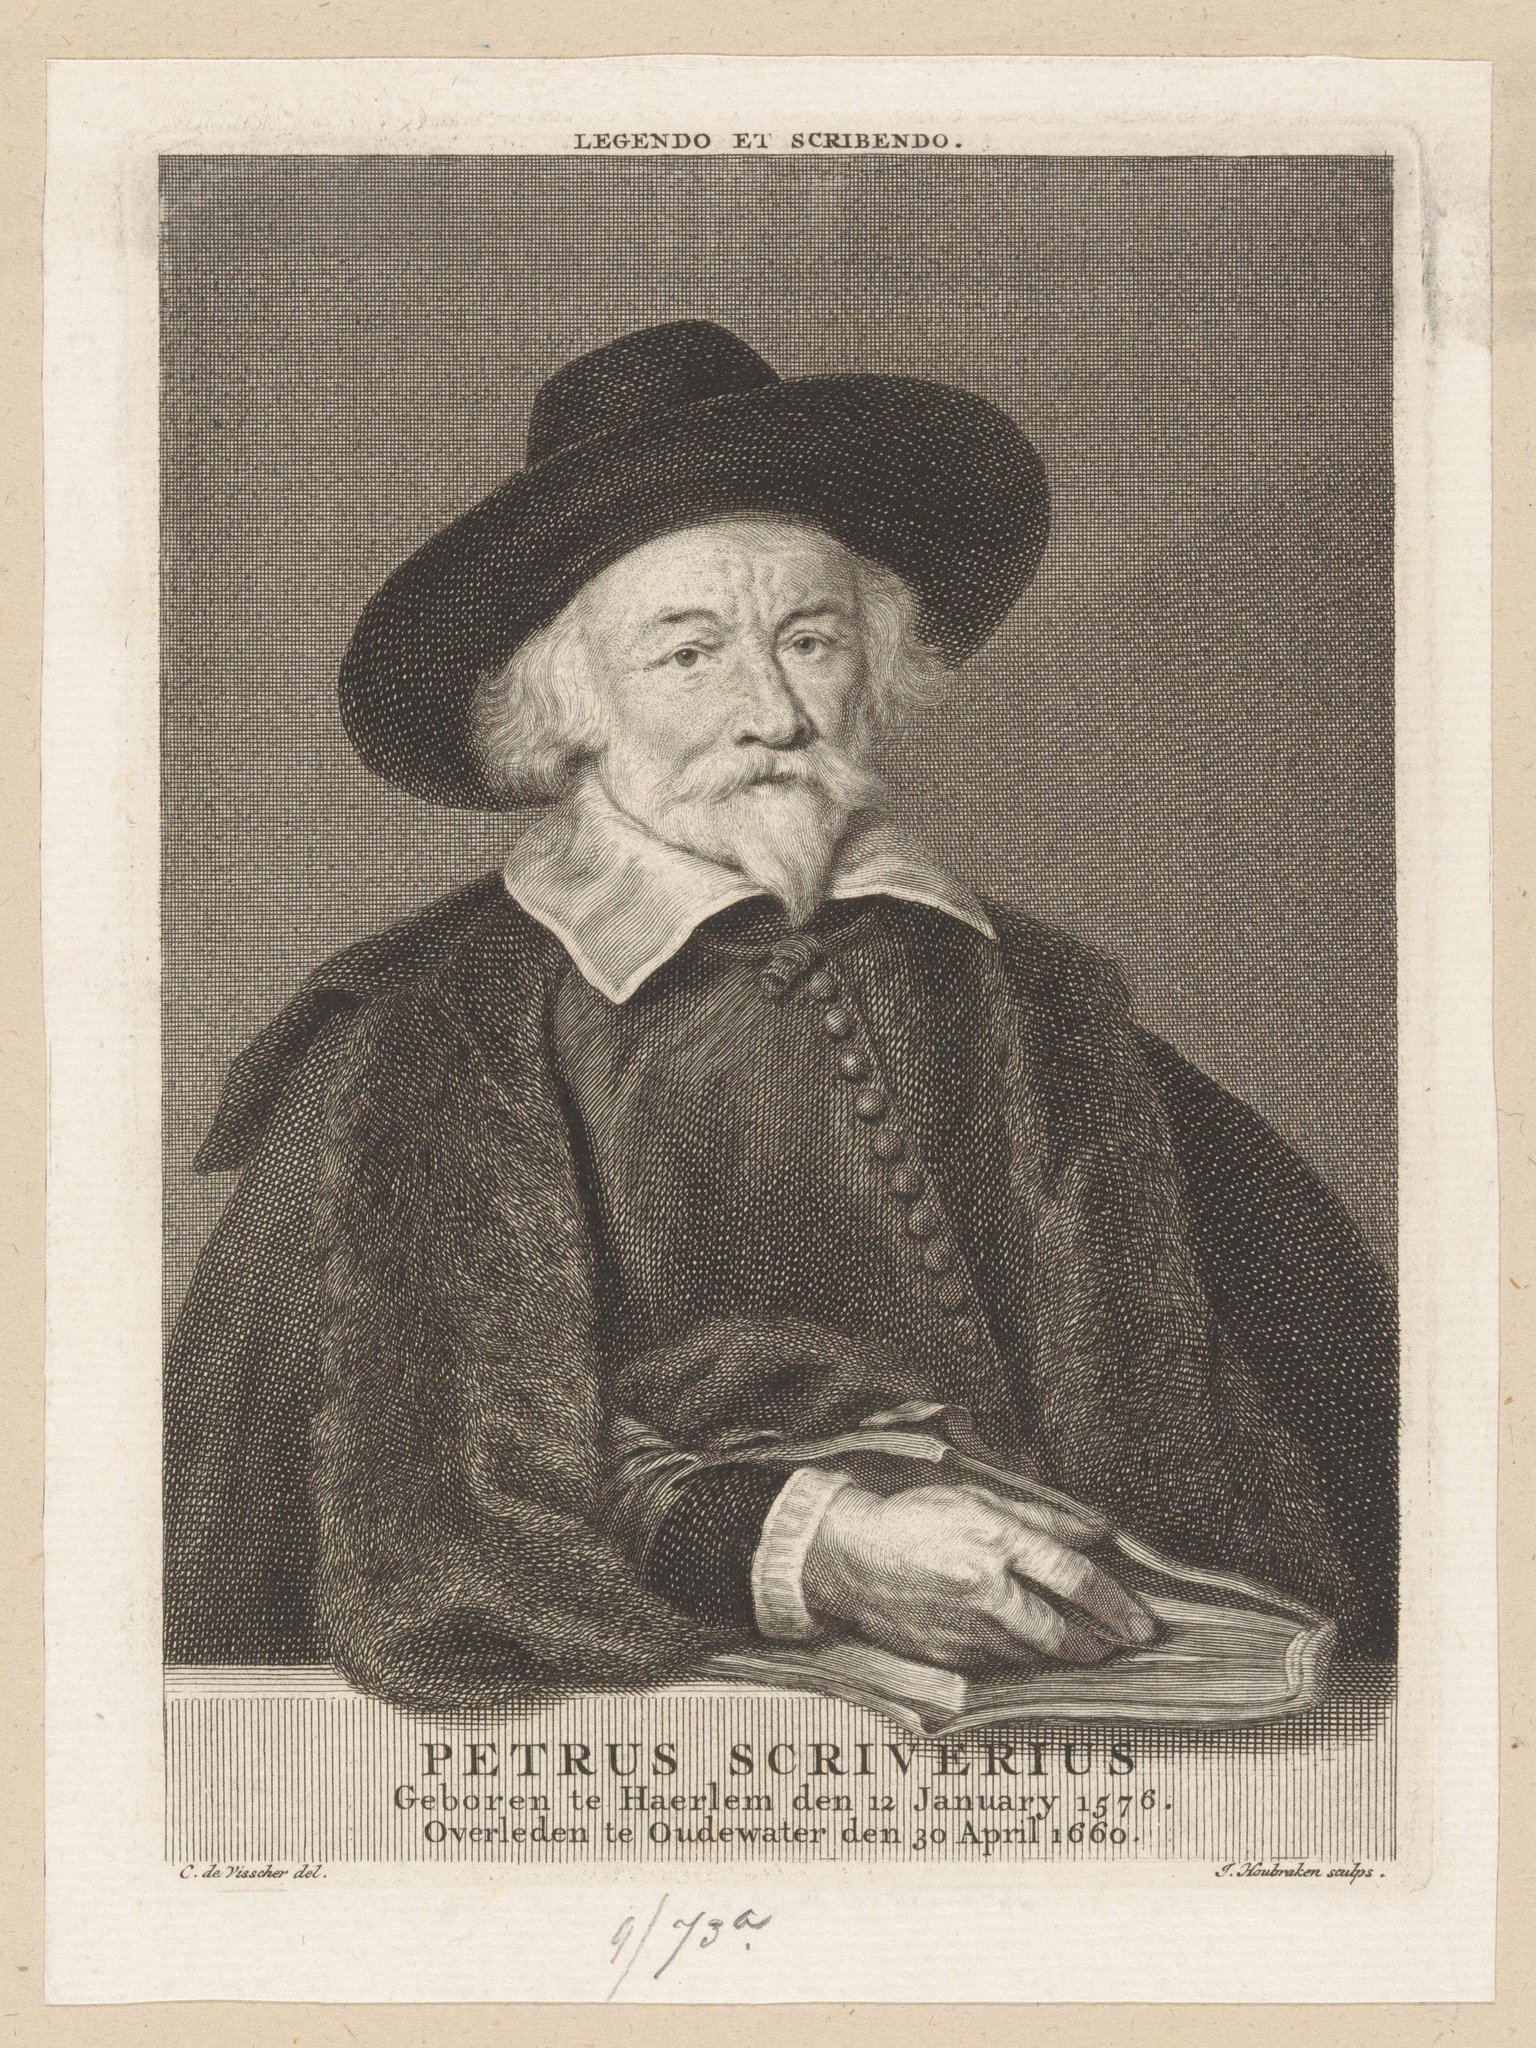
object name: print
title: Portret van Petrus Scriverius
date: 1710-1780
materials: paper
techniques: engraving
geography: amsterdam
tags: petrus scriverius, historical persons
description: Portret ten halven lijve naar rechts van Petrus Scriverius, zijn hand rustende op een boek op een plint voor hem. Bovenaan een regel in het Latijn en onderaan de naam en gegevens van de geportretteerde in drie regels in het Nederlands.